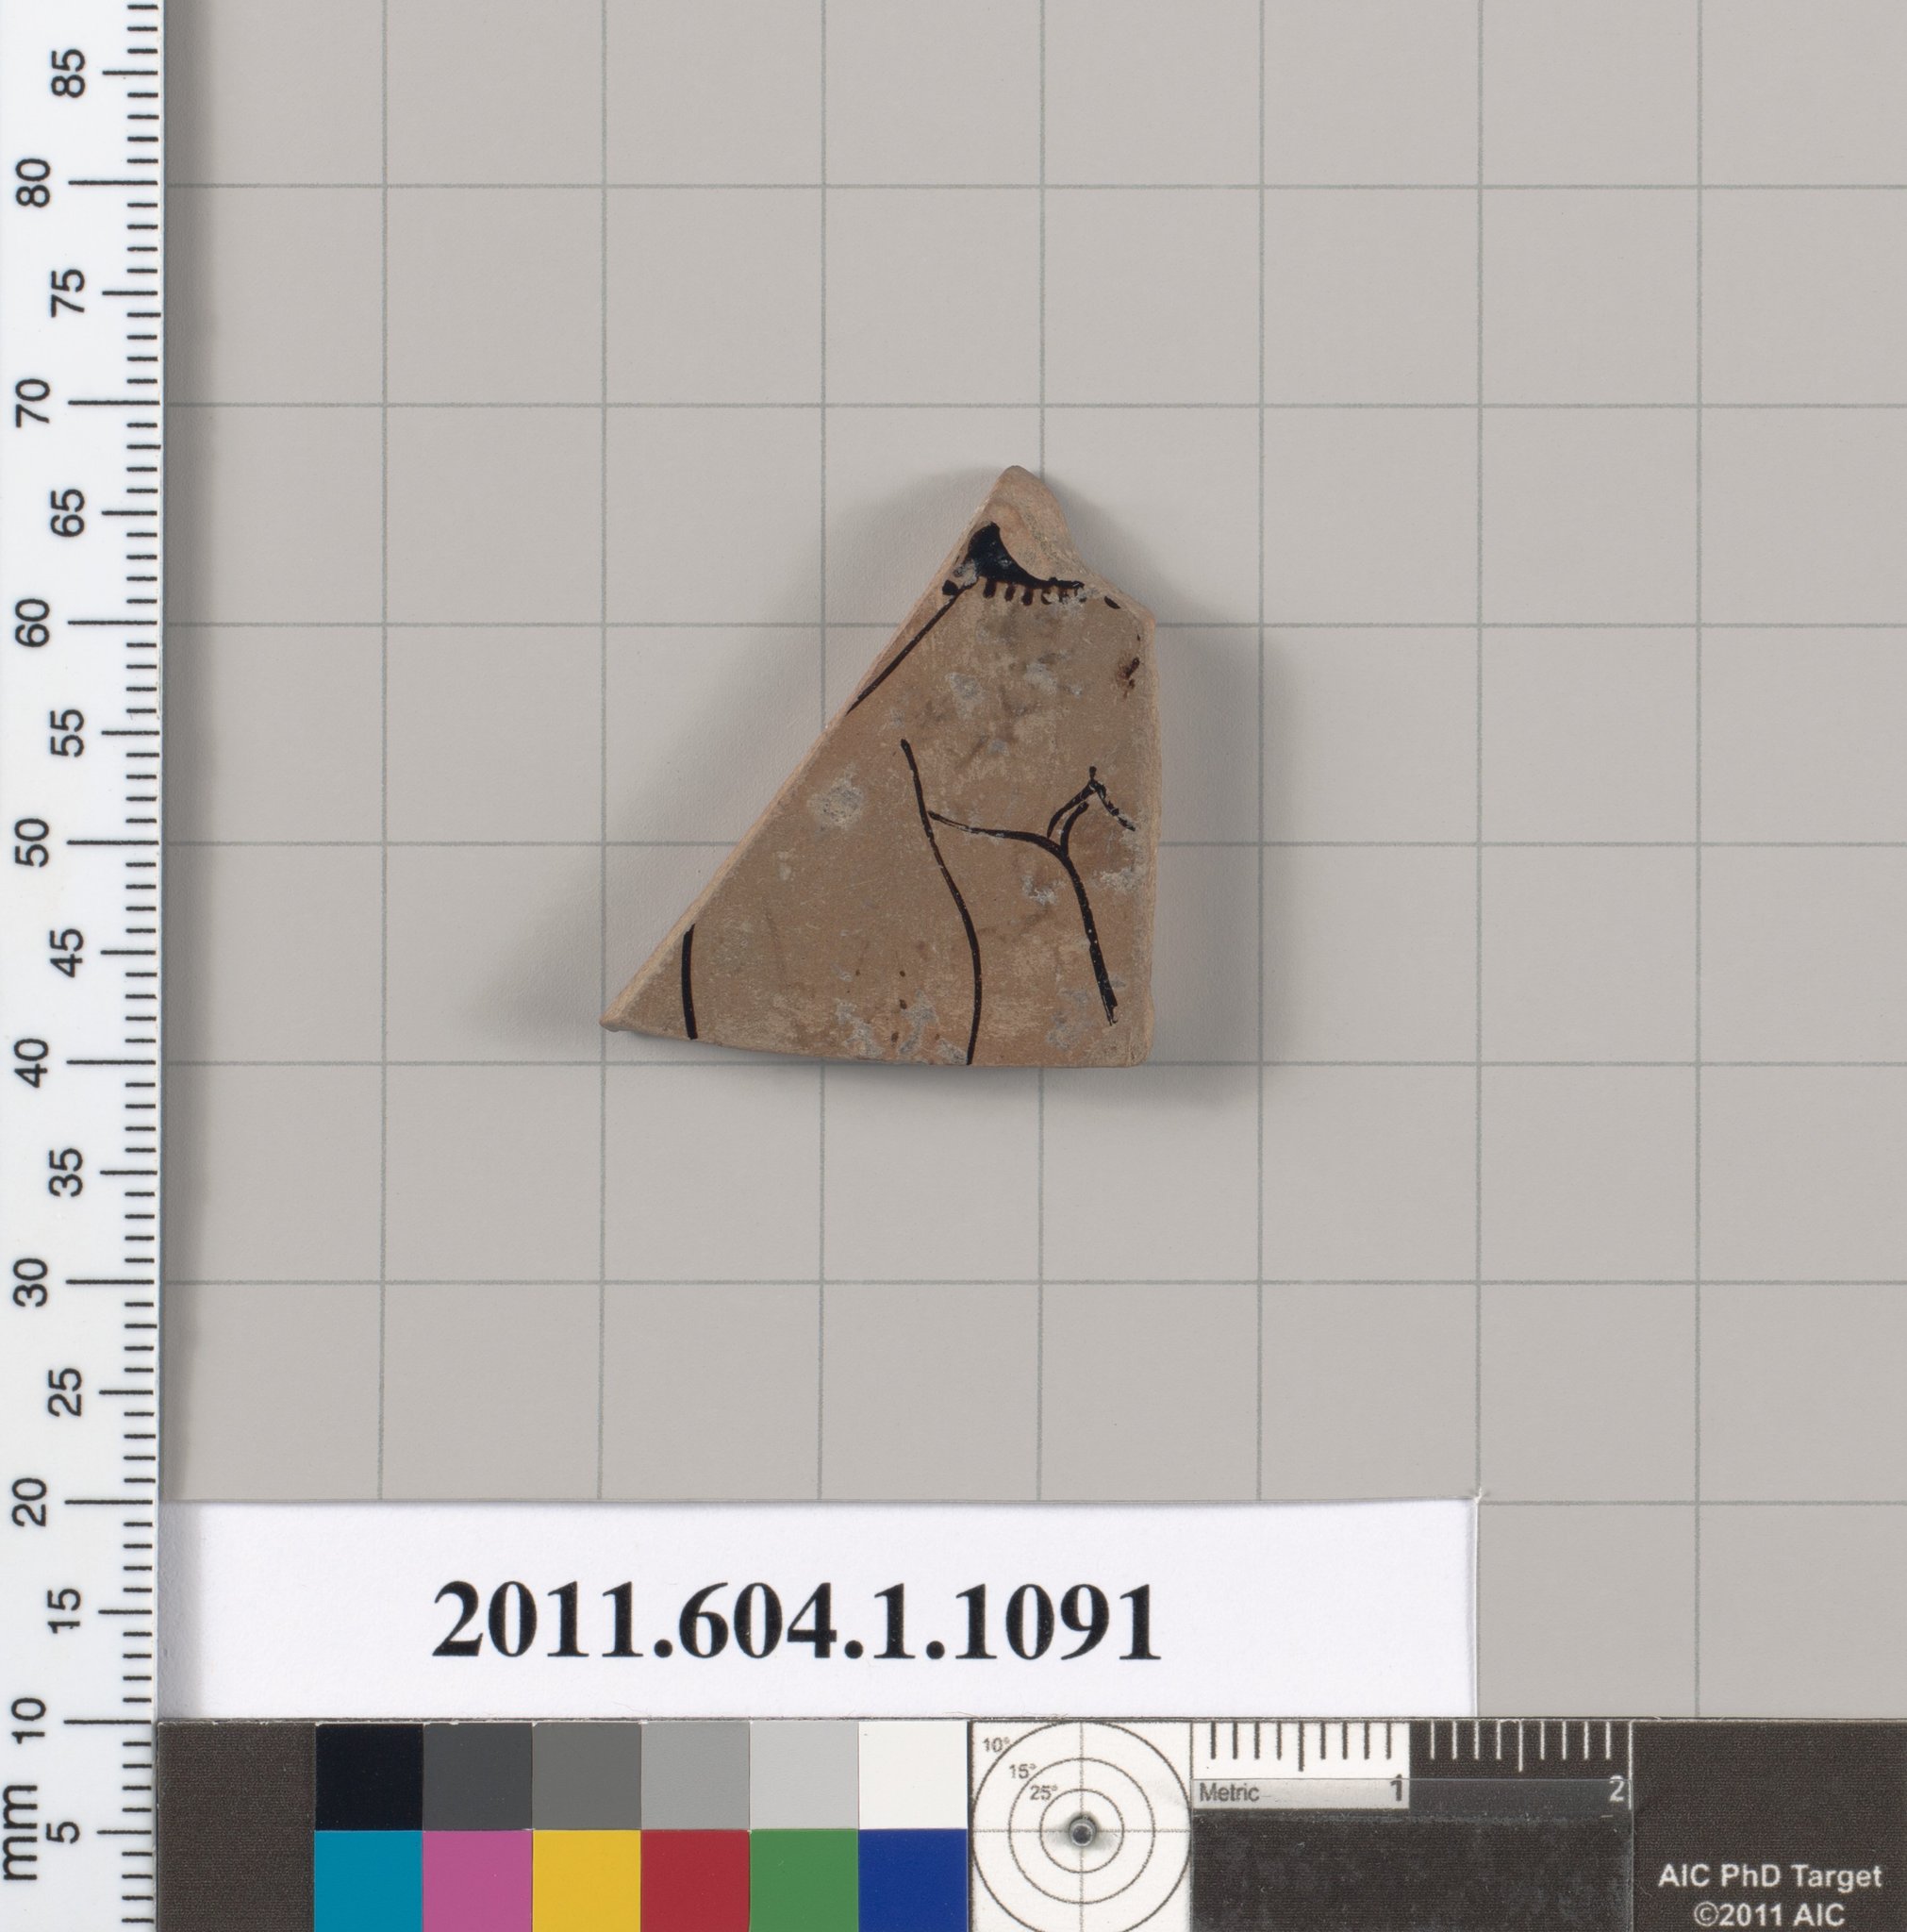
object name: kylix fragment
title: Terracotta fragment of a kylix (drinking cup)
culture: greek, attic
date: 500-480 BCE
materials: terracotta